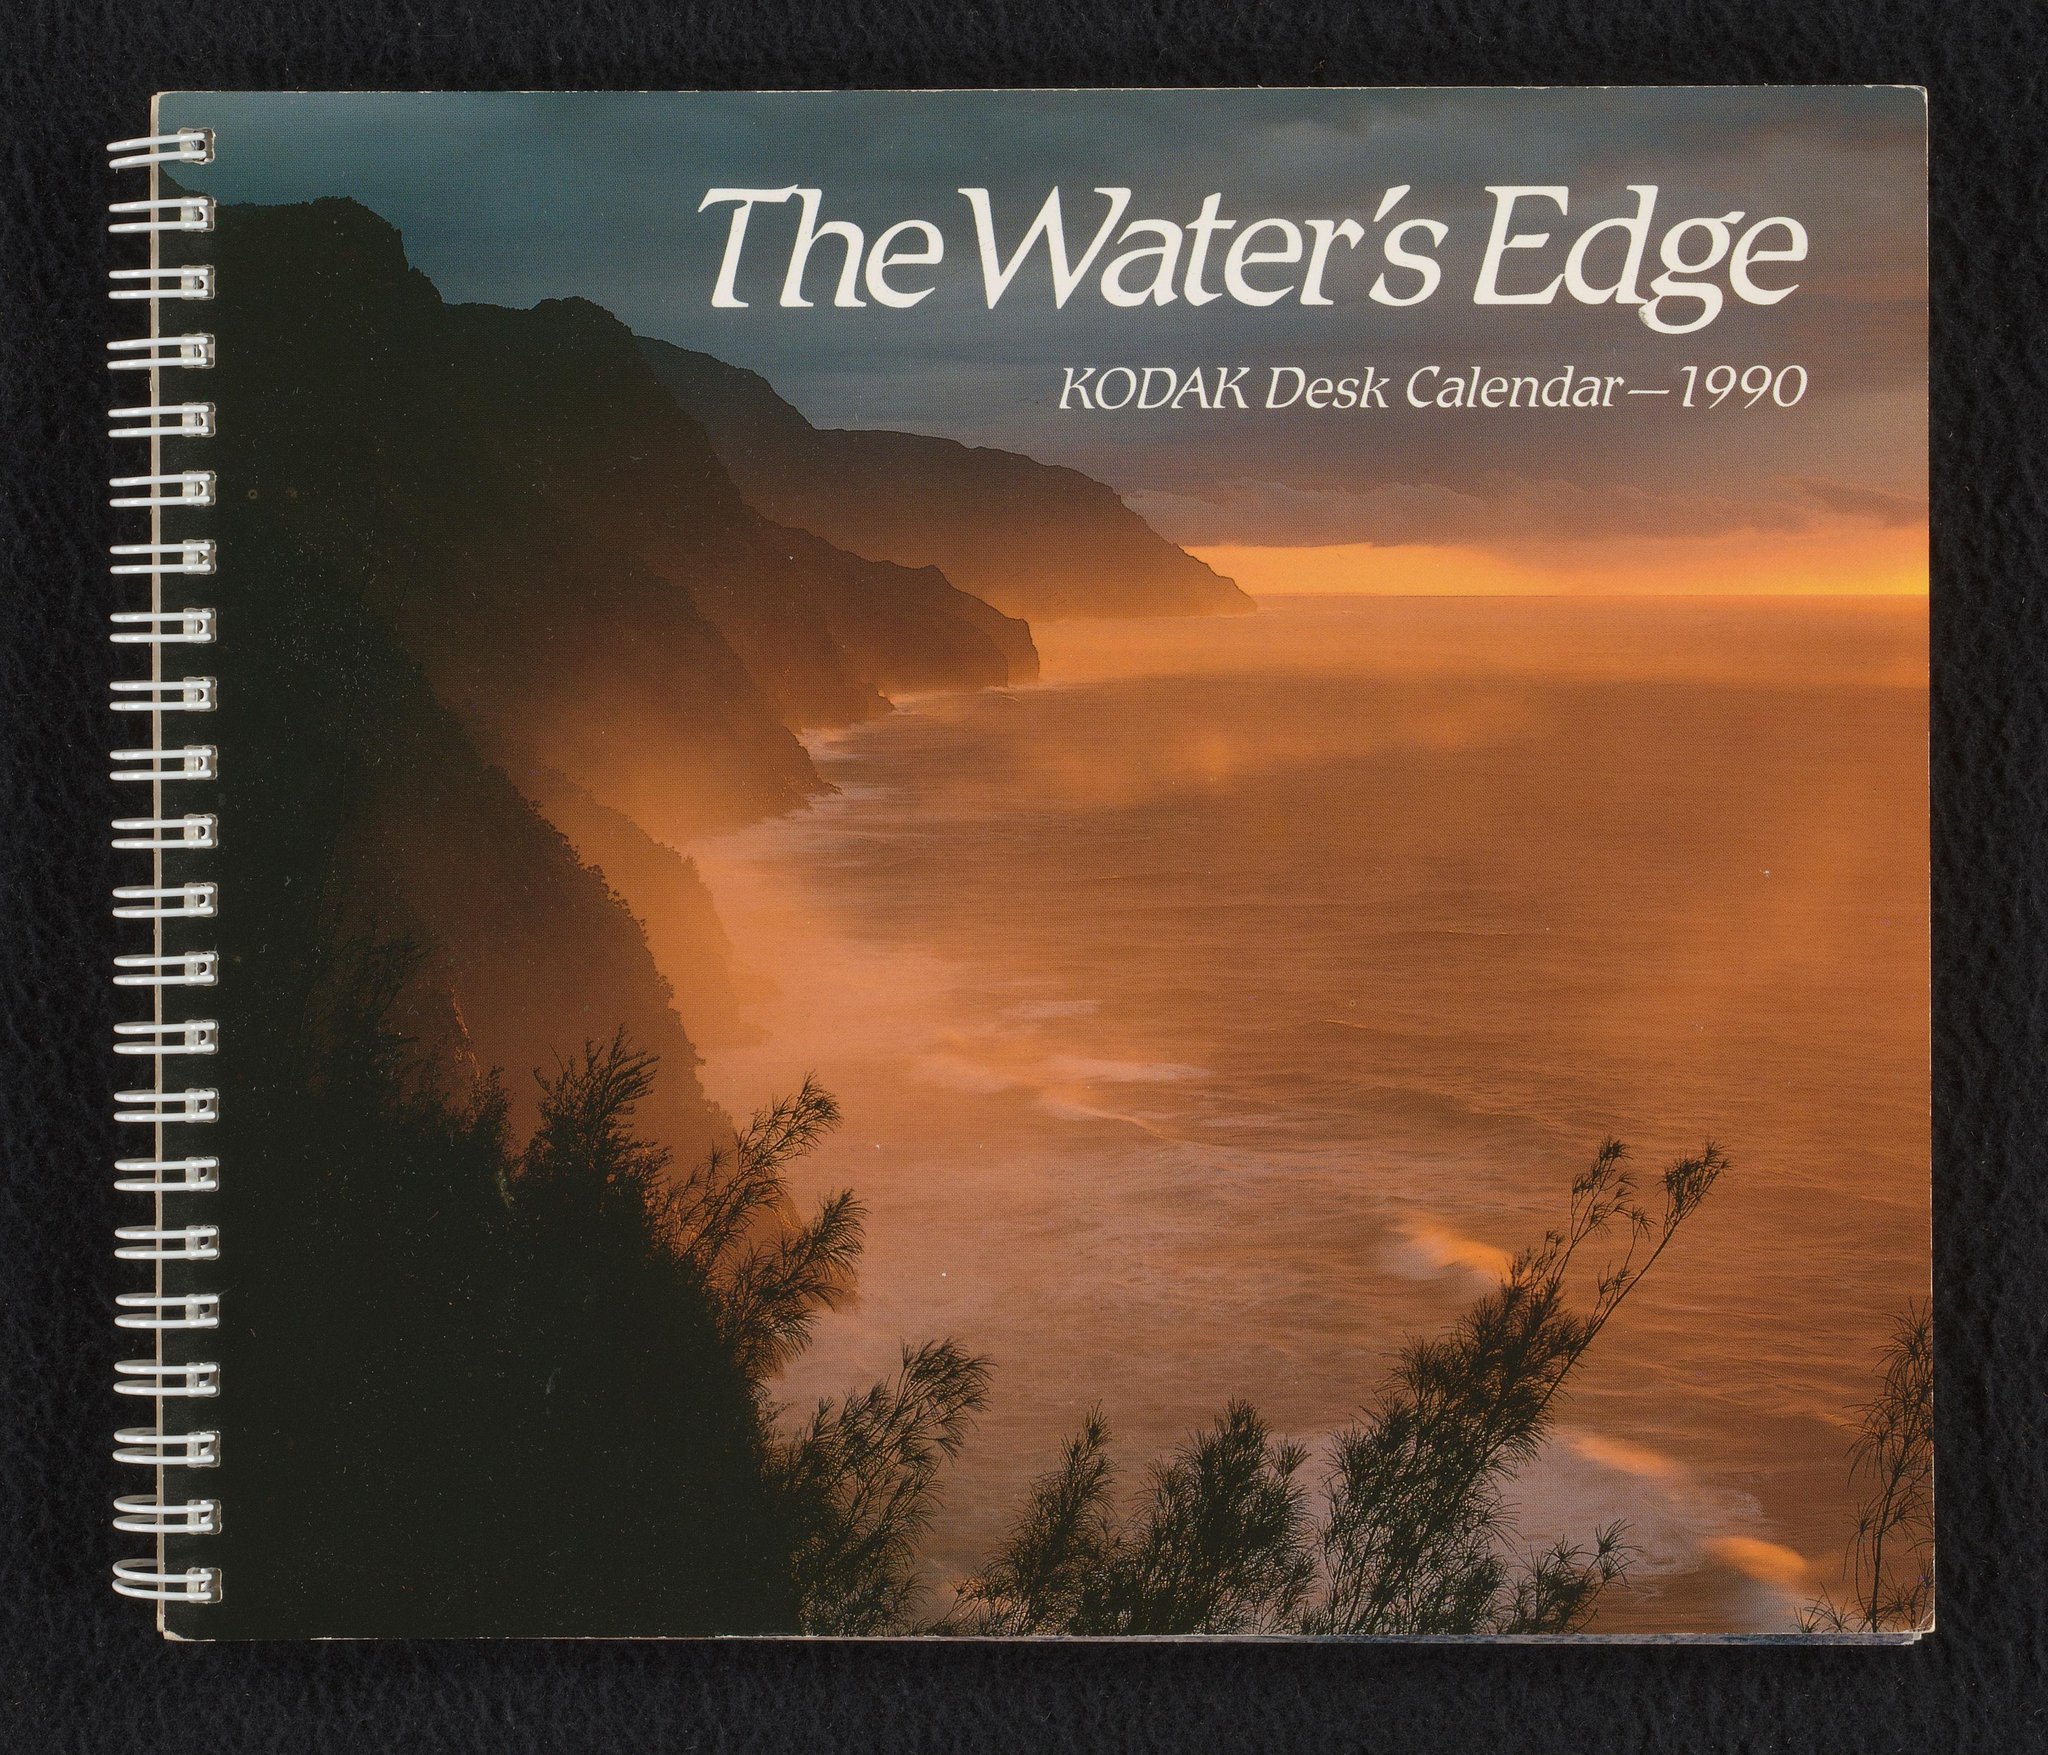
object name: calendar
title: Kalender uit 1990 van Eastman Kodak met 52 kustgezichten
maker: mary-helen maginn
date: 1989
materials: metal, paper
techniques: inkjet print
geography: united states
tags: calendar, almanac, united states of america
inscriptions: inscription: ‘A 53-week display of fascinating images for all who appreciate the special appeal of nature/ photography (...)/ KODAK Publication AC-118S/ CAT 199 8673 ISBN 0-87985-620-3/ $9.95 USA’, copyright notice: ‘© Eastman Kodak Company, 1989’